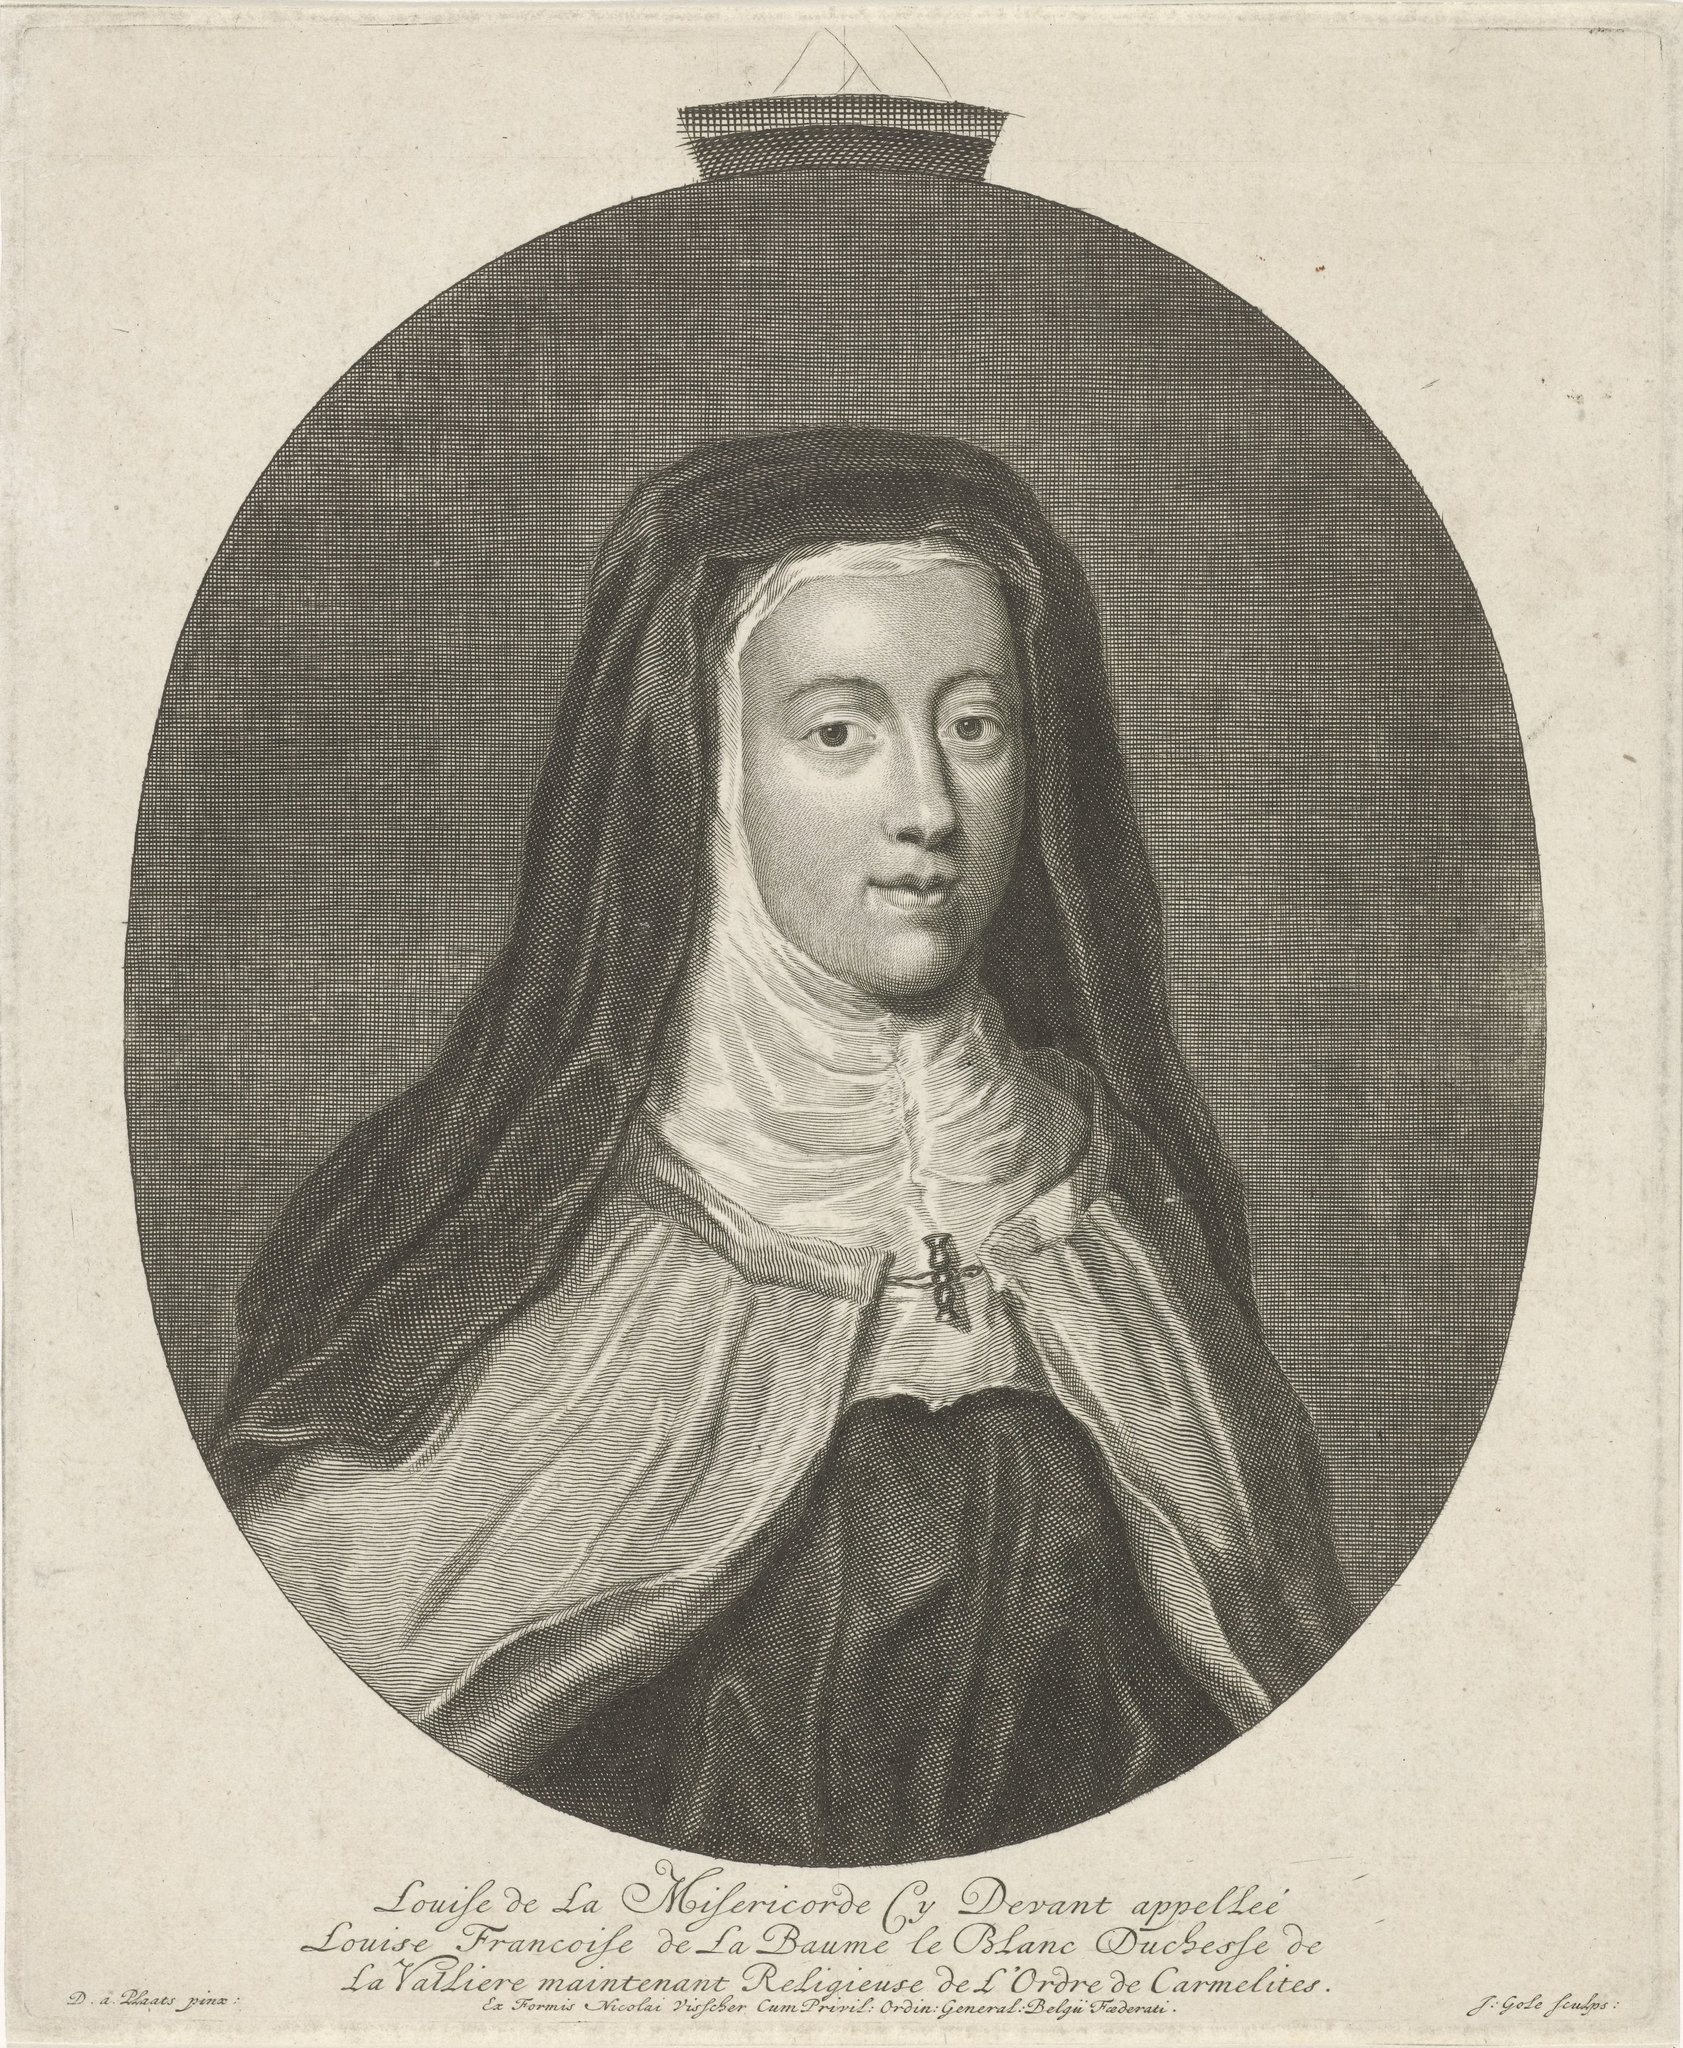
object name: print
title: Portret van Louise de la Misericorde, alias Françoise de La Baume Le Blanc de la Vallière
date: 1670-1724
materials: paper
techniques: engraving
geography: amsterdam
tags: paris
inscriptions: collector's mark: Lugt 2228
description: Portret in ovale lijst van Louise Françoise de La Baume Le Blanc de la Vallière, nadat ze toegetreden was tot de orde van carmelieten en ze de naam Louise de la Misericorde had opgenomen. Ten halven lijve naar rechts. De prent heeft een Frans onderschrift.